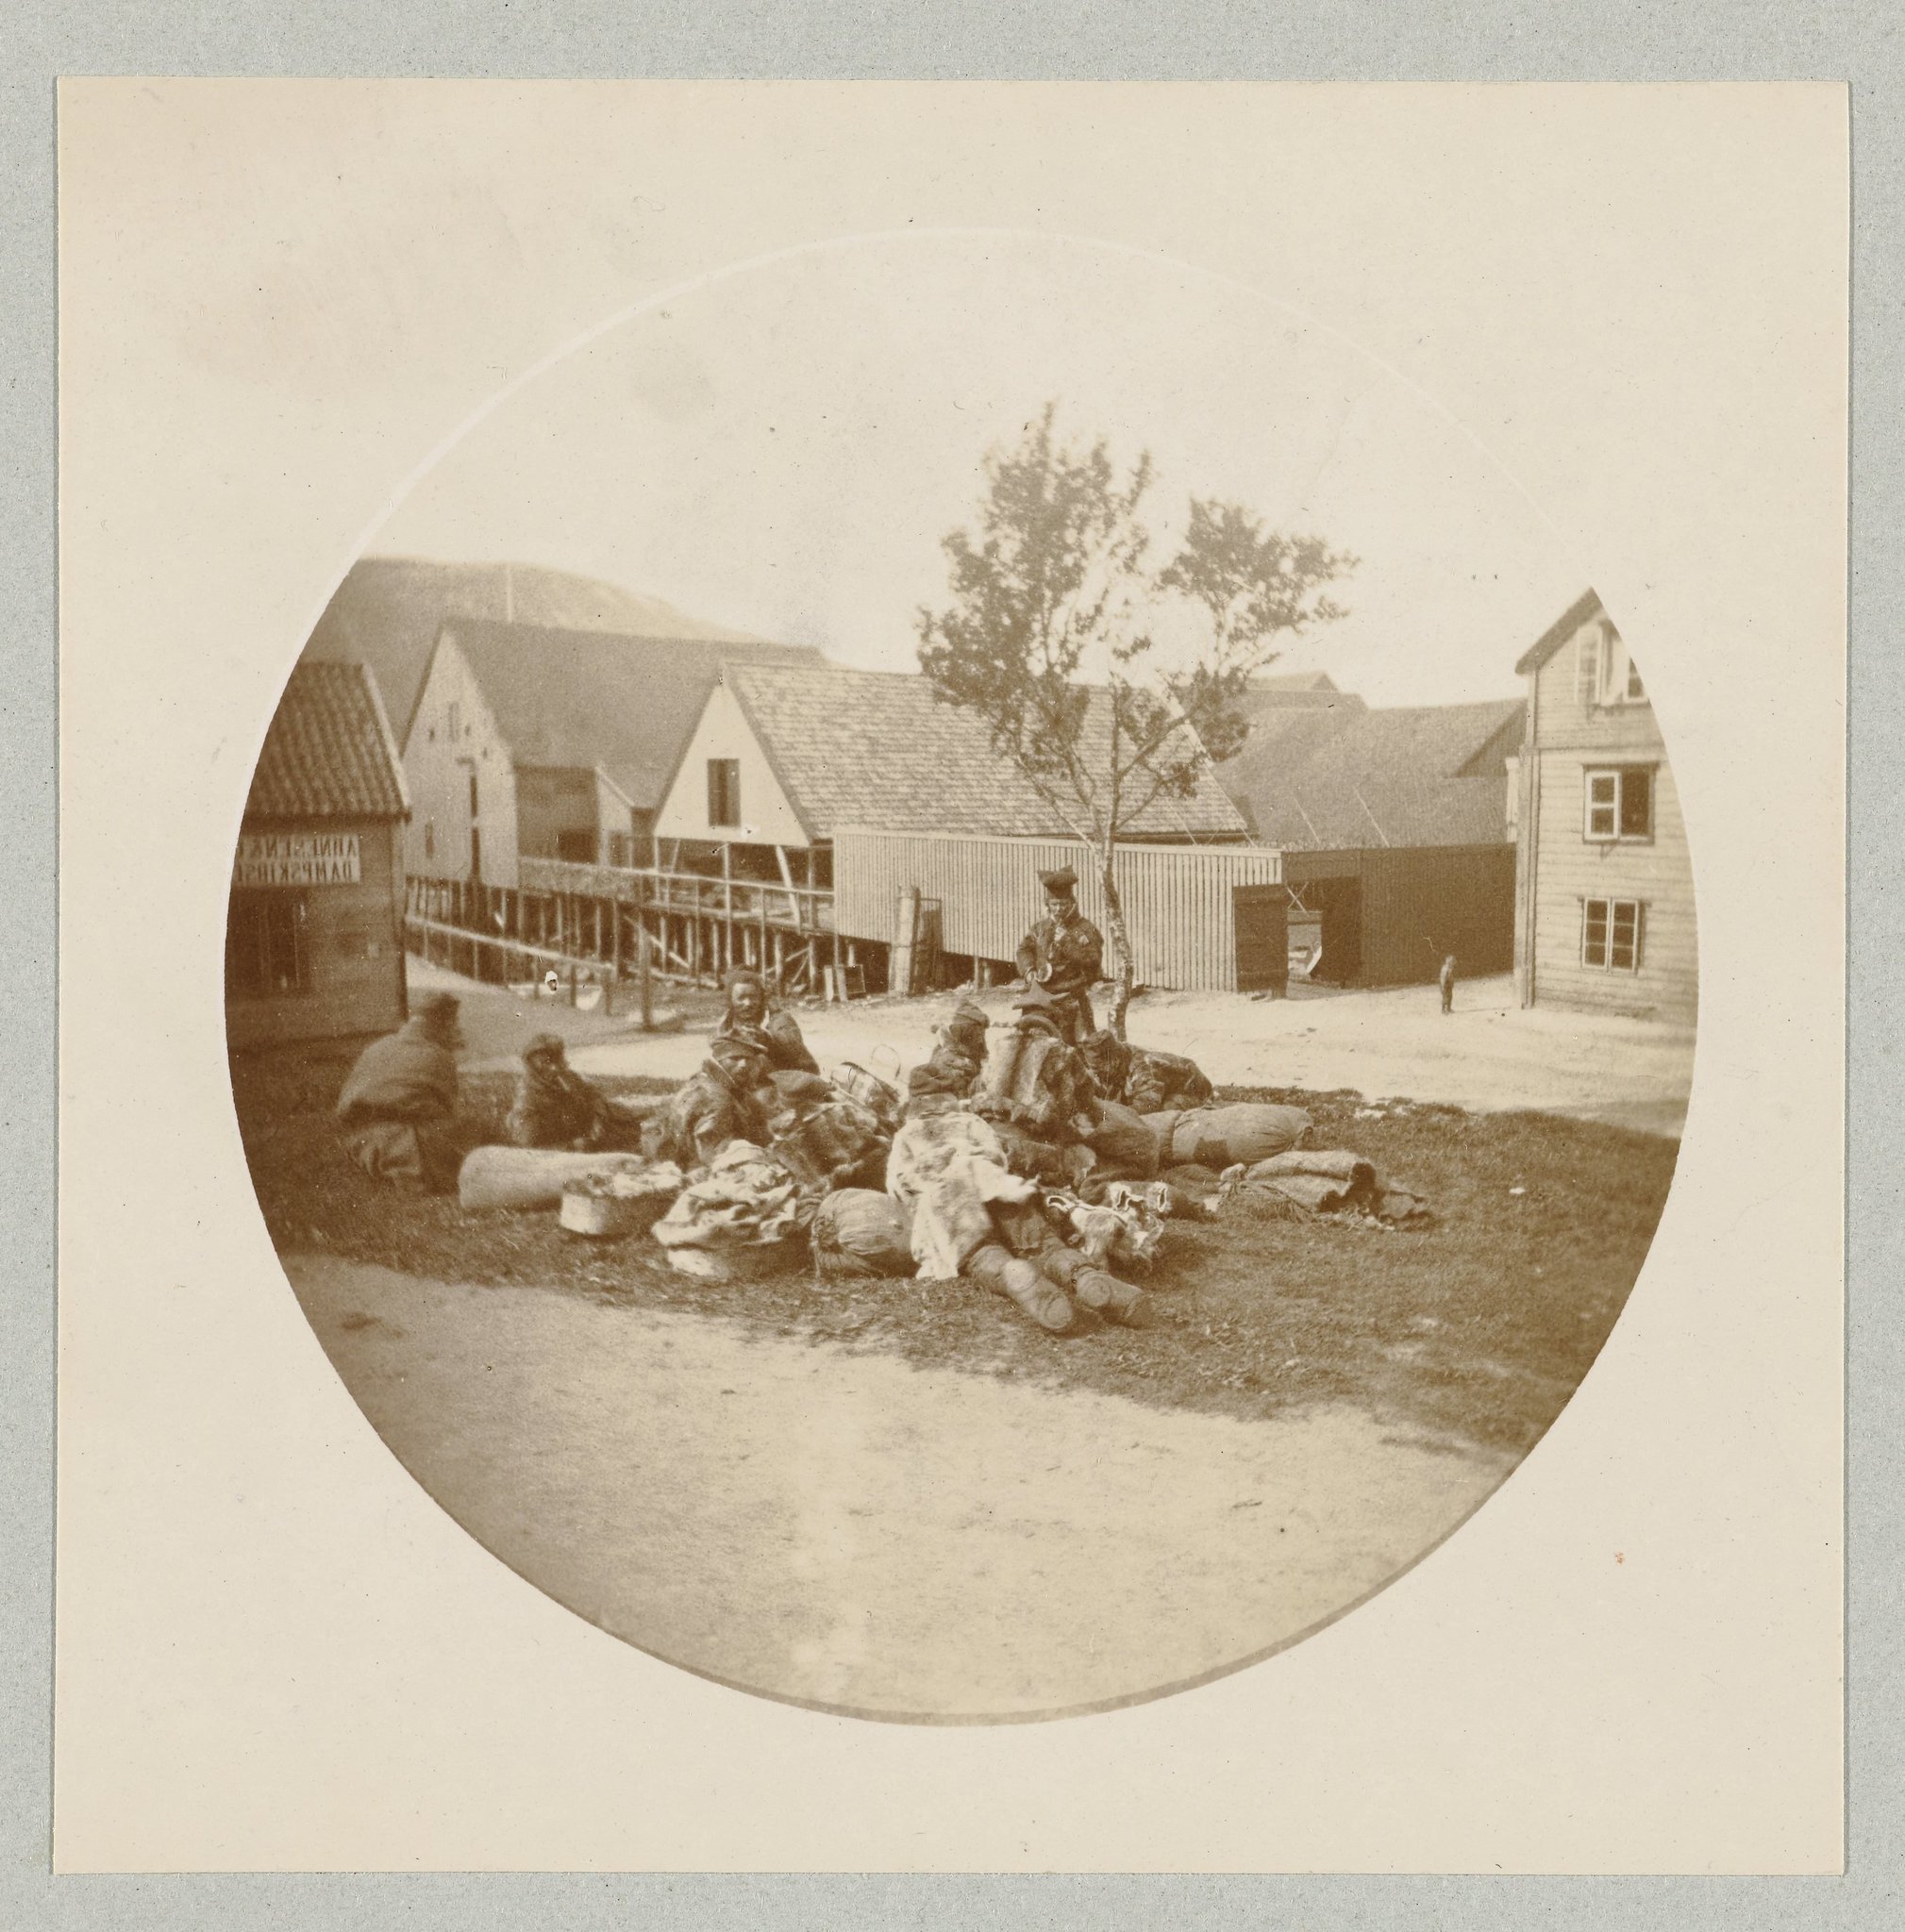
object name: photograph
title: Groep mannen in dikke kleding op een veld, mogelijk Sami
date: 1807-1889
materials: cardboard, paper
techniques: gelatin silver print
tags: wilhelm ii (keizer van duitsland), europeans: sami, sápmi, norway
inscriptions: number: ‘32’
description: De afdruk van de foto is rond, het papier vierkant. foto gemaakt met Nr. 1 Kodak Camera